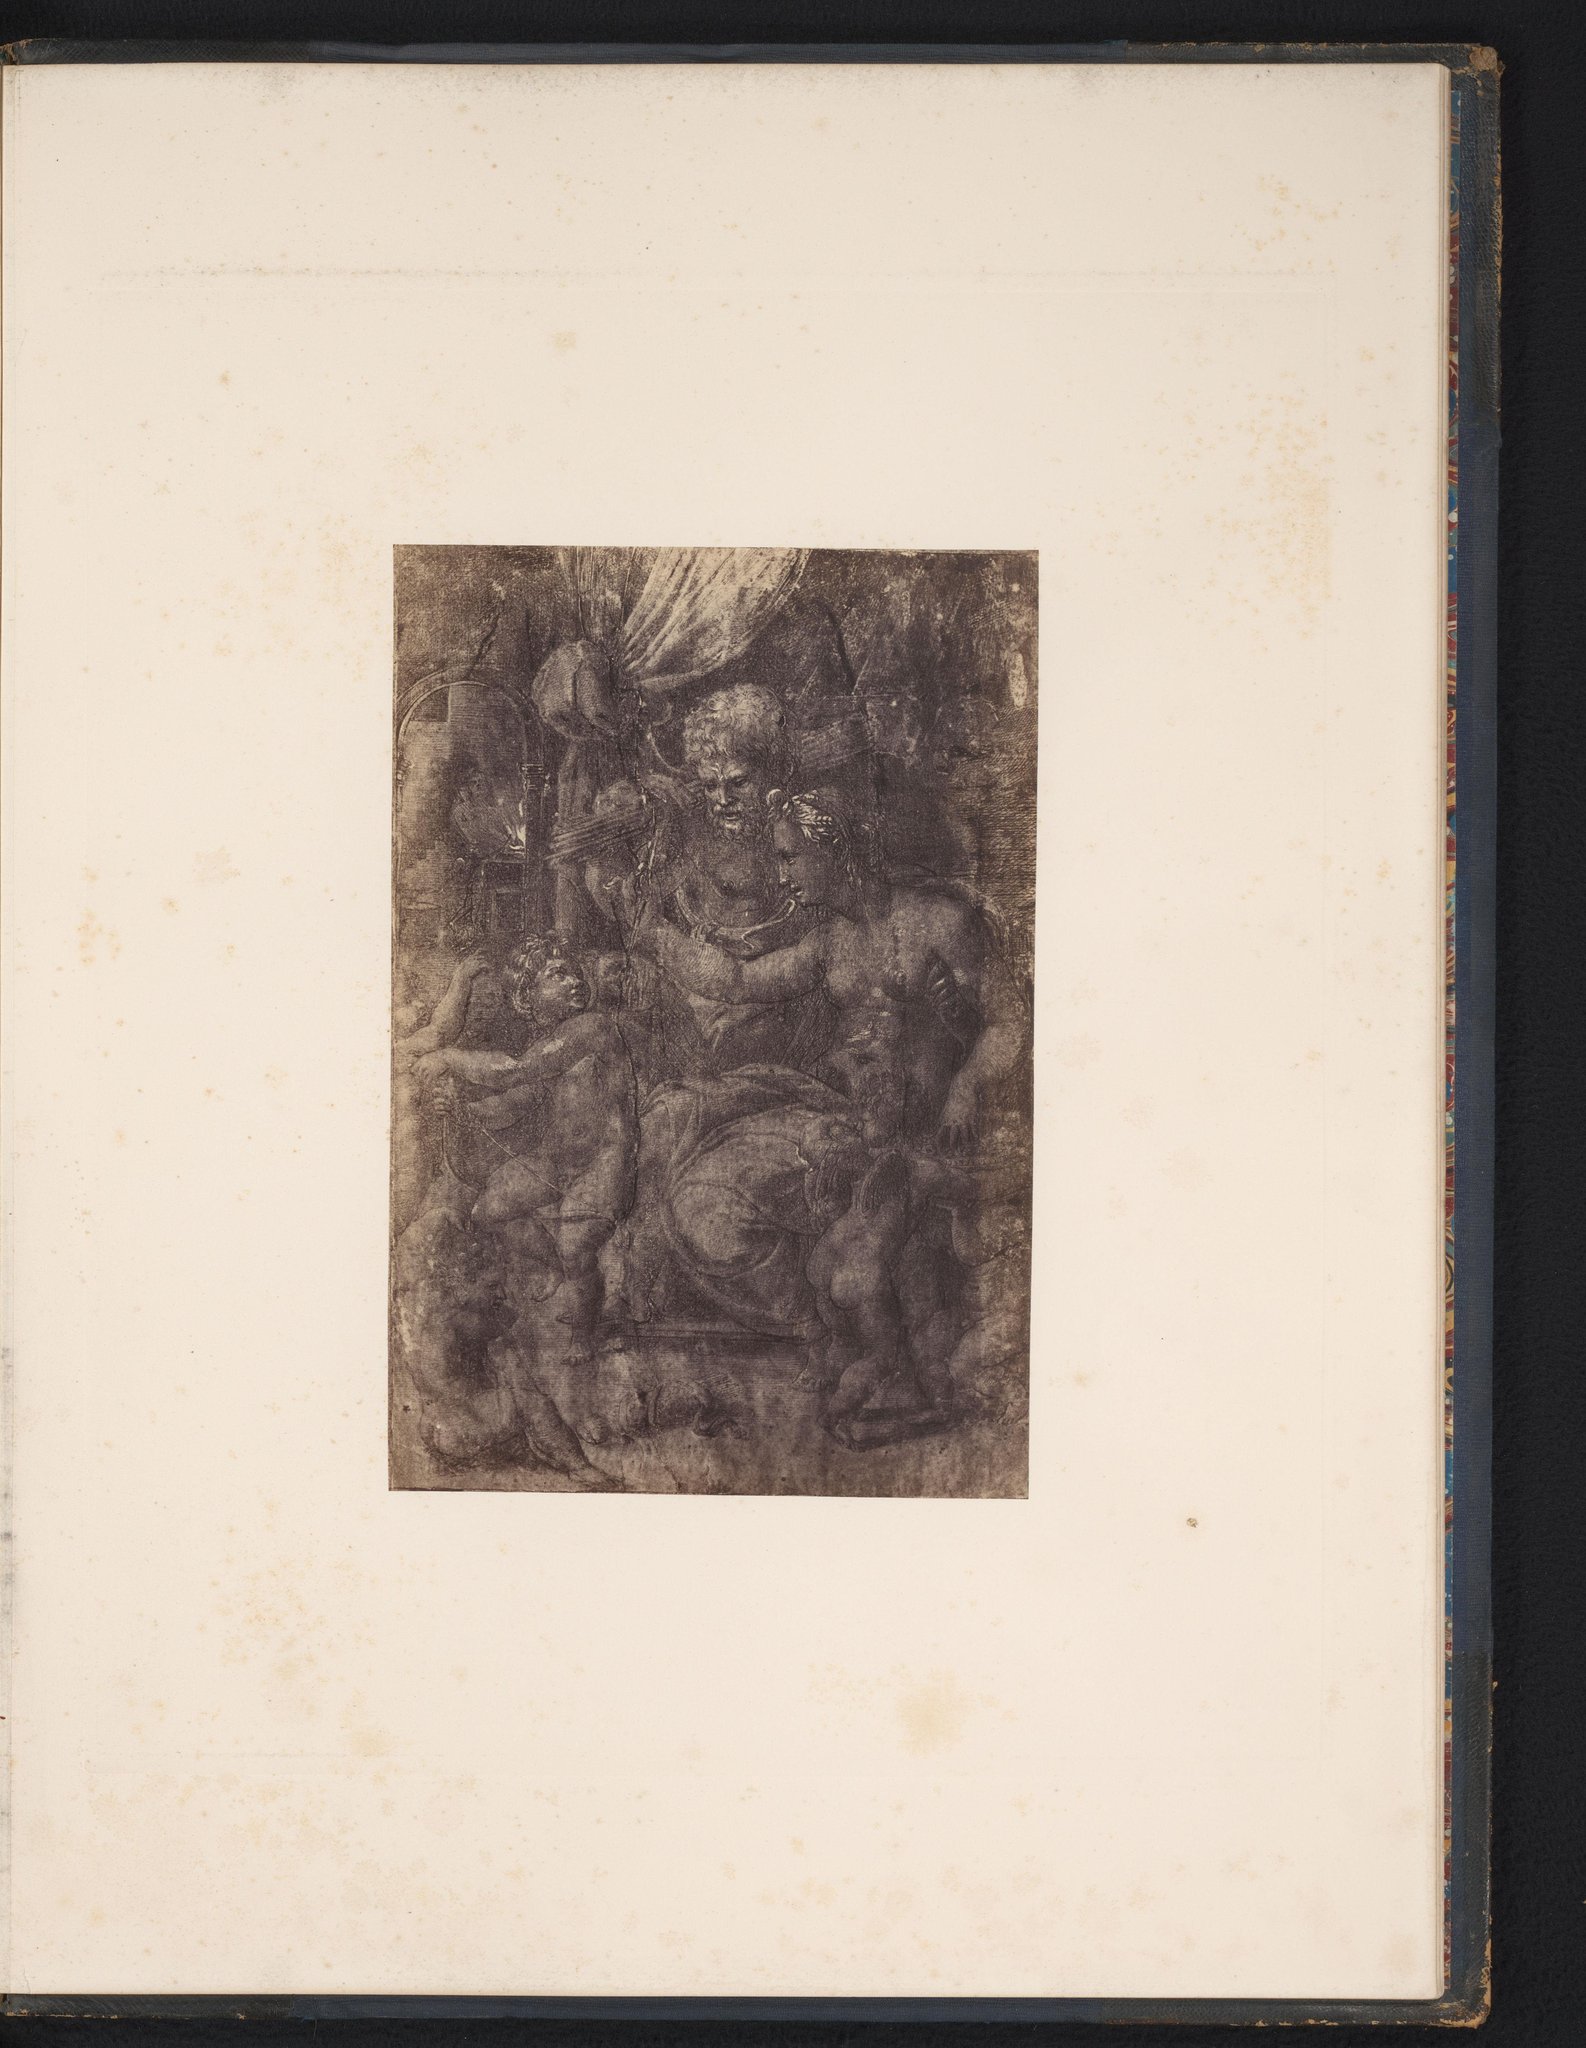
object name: reproduction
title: Fotoreproductie van een tekening van Rafaël, Heilige Familie met engelen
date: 1852-1857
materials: paper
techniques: albumen print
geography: windsor castle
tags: holy family, and derived representations